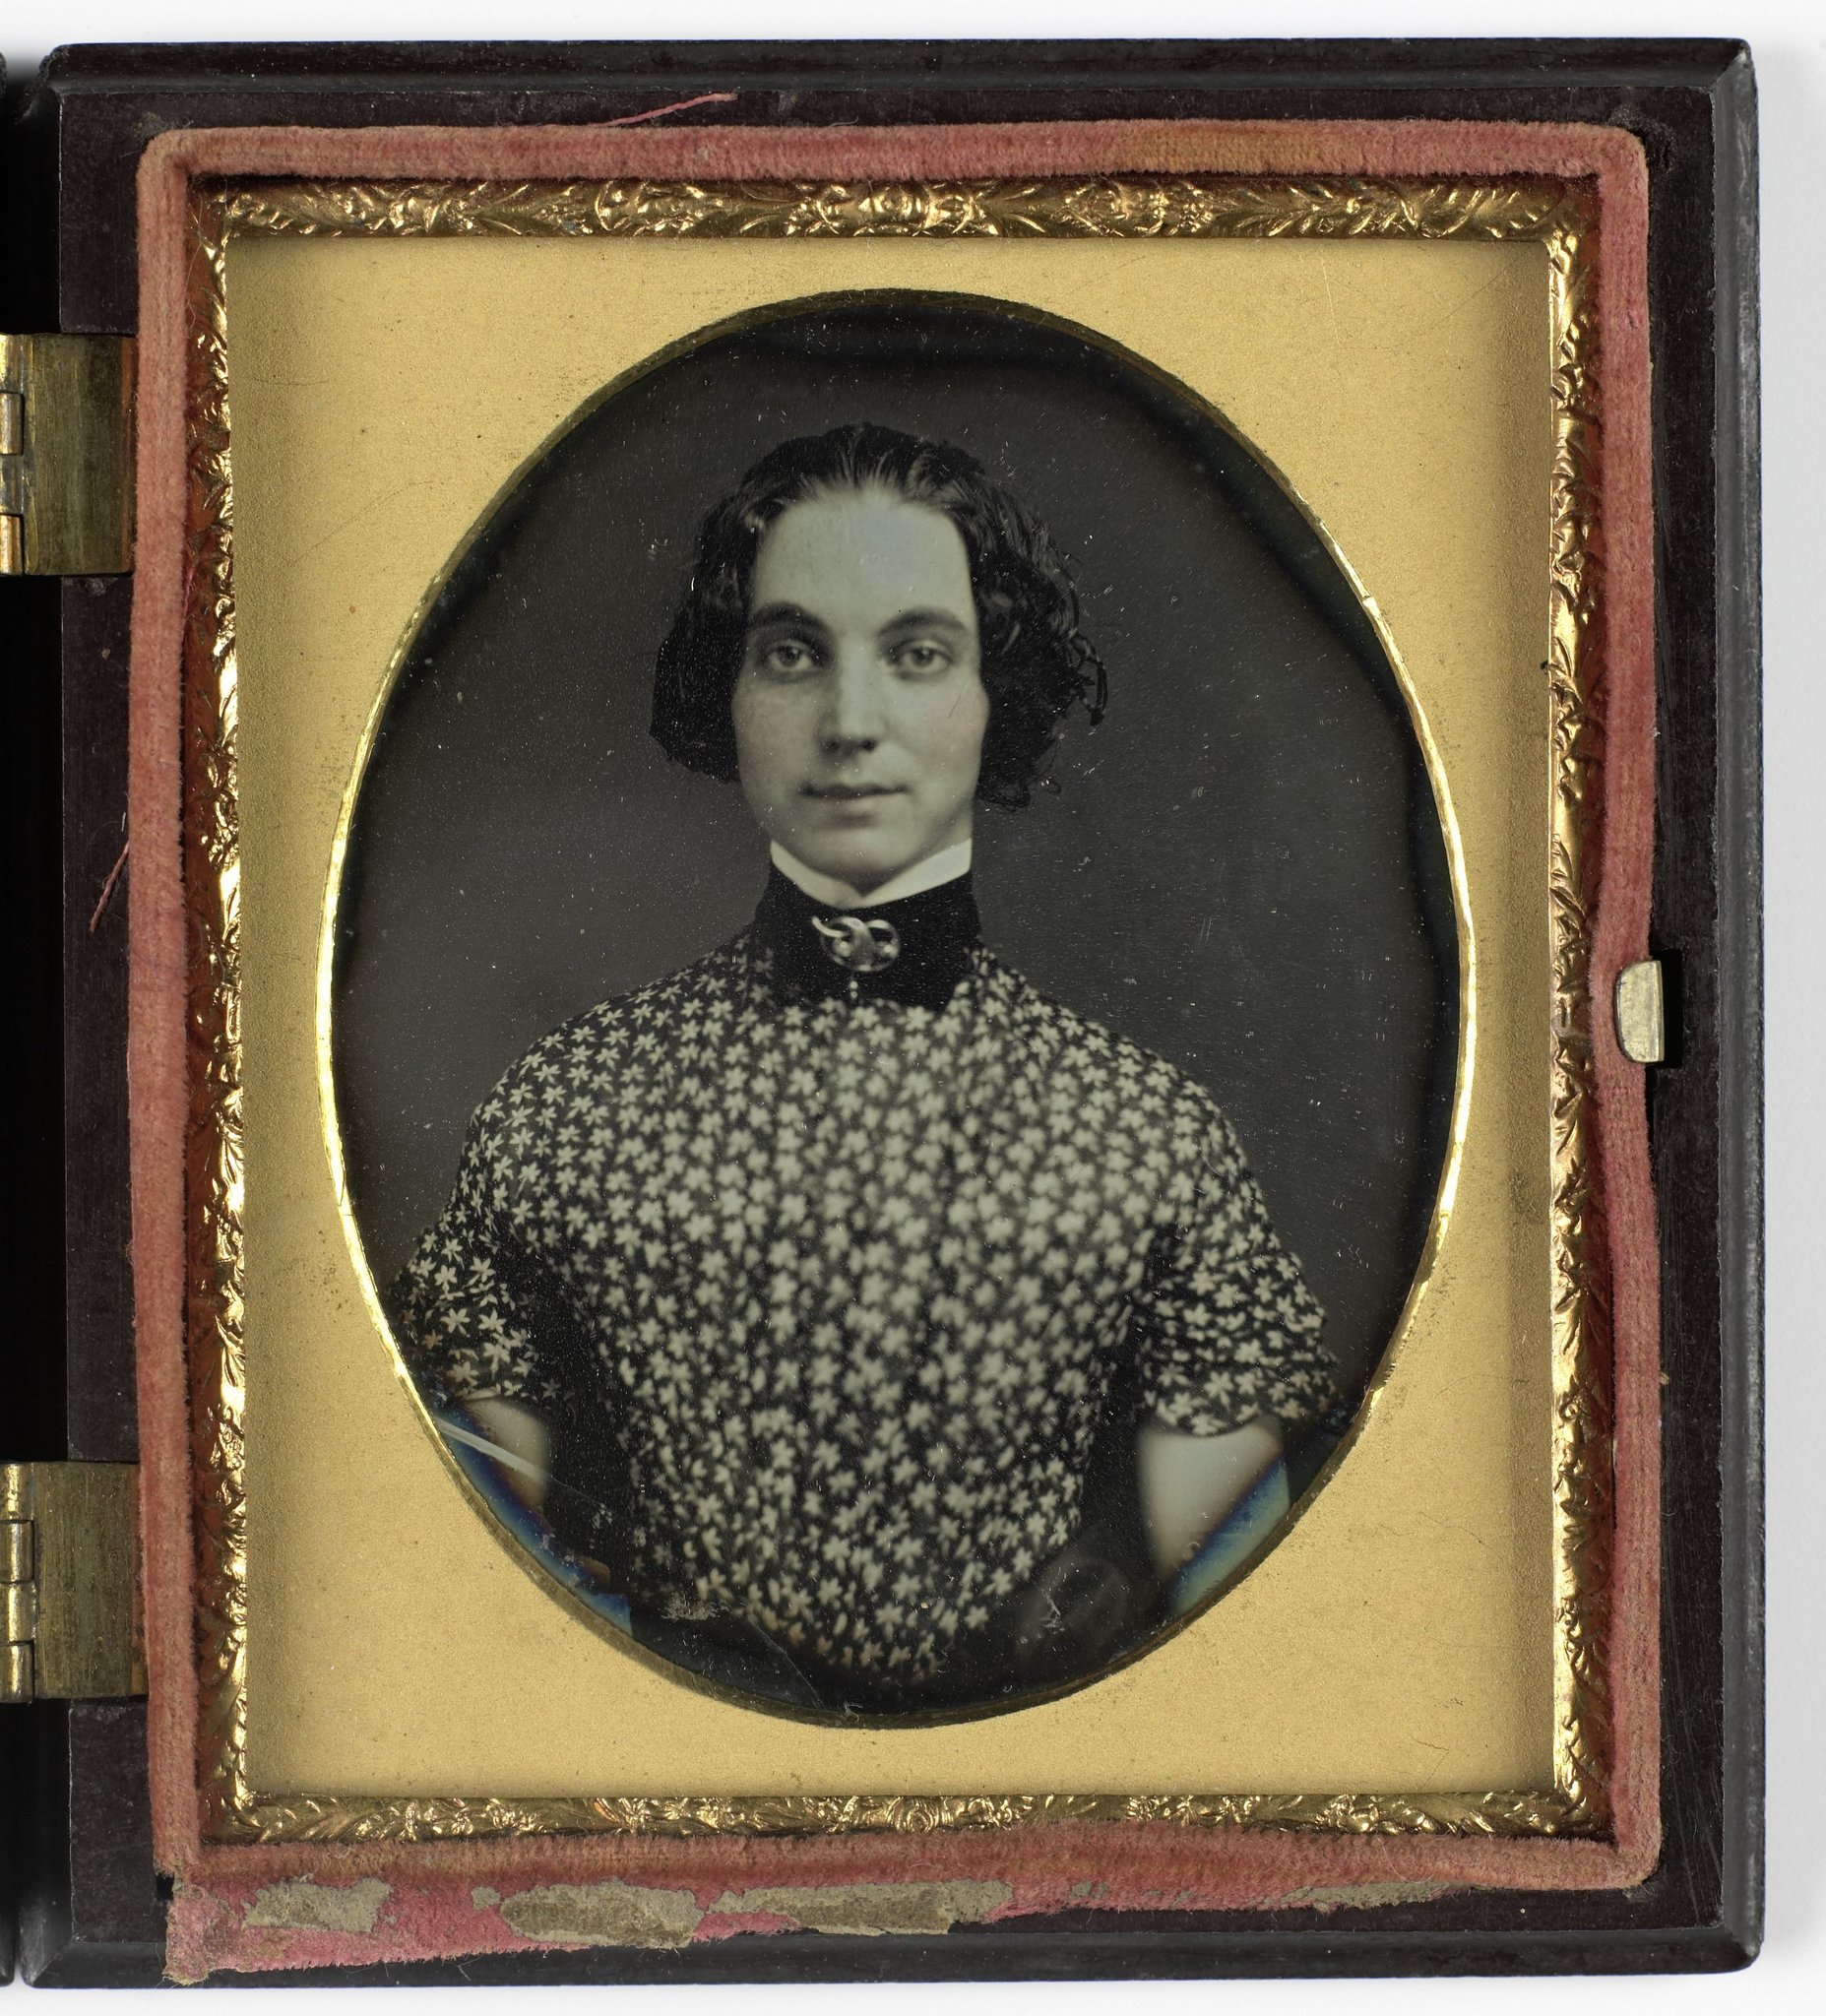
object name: photograph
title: Portret van een onbekende jonge vrouw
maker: Anonymous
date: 1840-1860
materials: copper, glass, plastic, velvet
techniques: daguerreotype, hand coloring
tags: adolescent, young woman, maiden, historical persons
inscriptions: inscription: ‘A.P. [...] & Co/ Manufacturers of Daguerreotype Cases/ [...] Patented Oct 14. 1856’